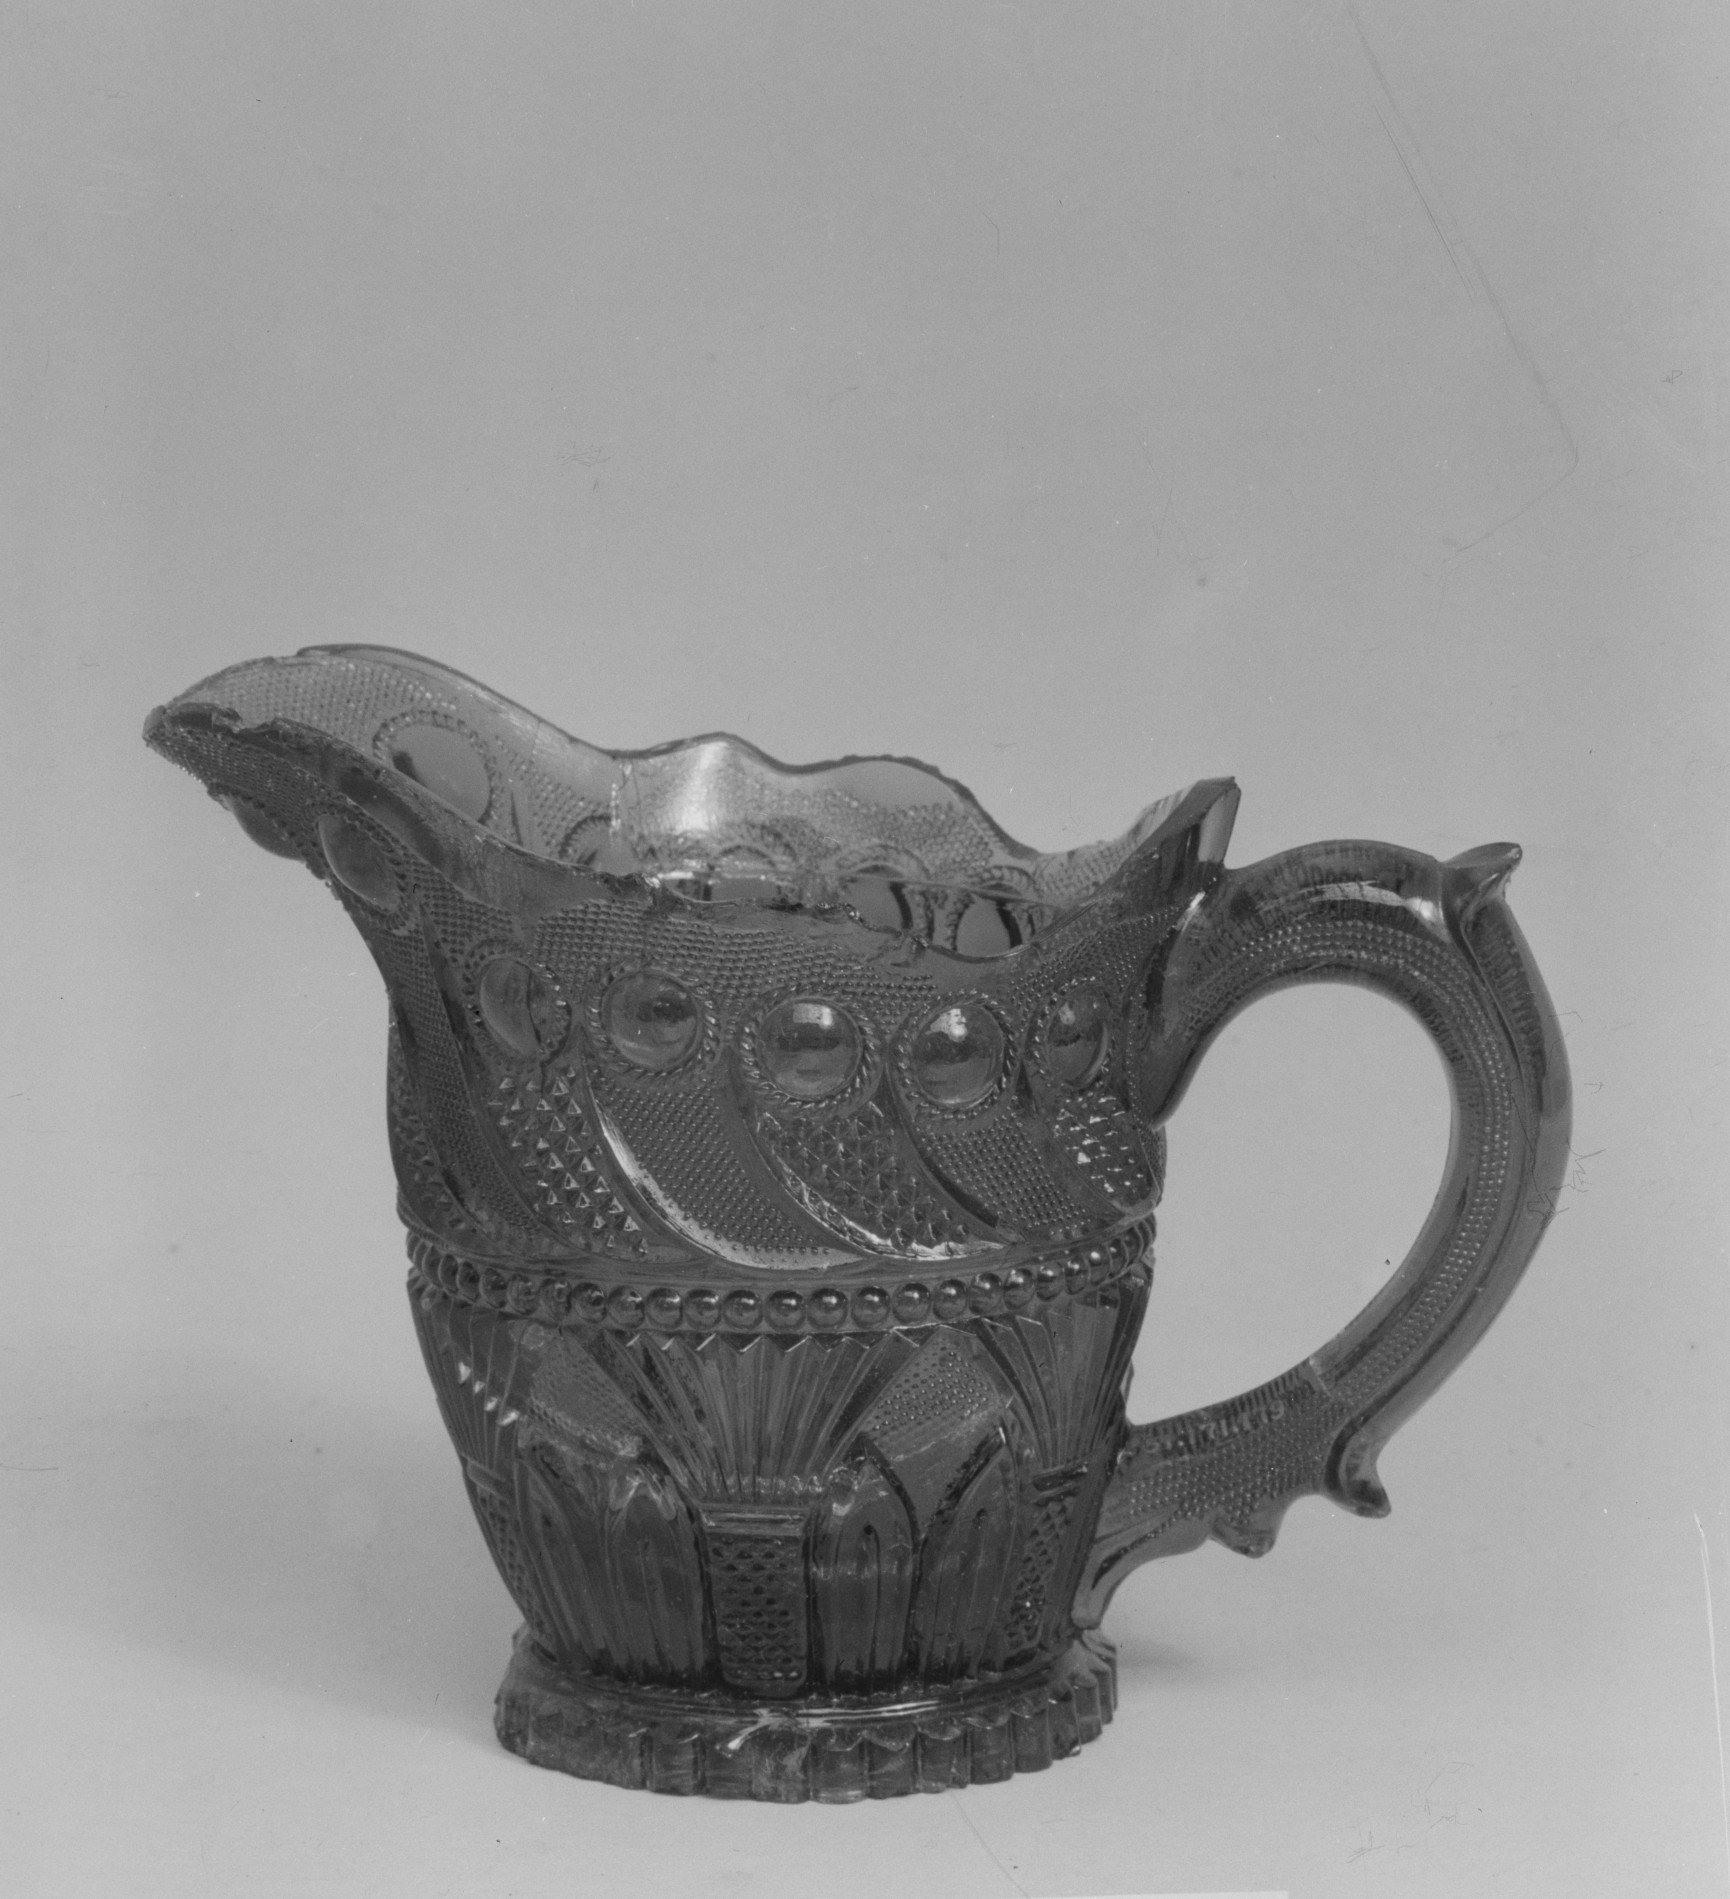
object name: cream pot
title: Creamer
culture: american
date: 1830-1840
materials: glass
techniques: pressed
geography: united states